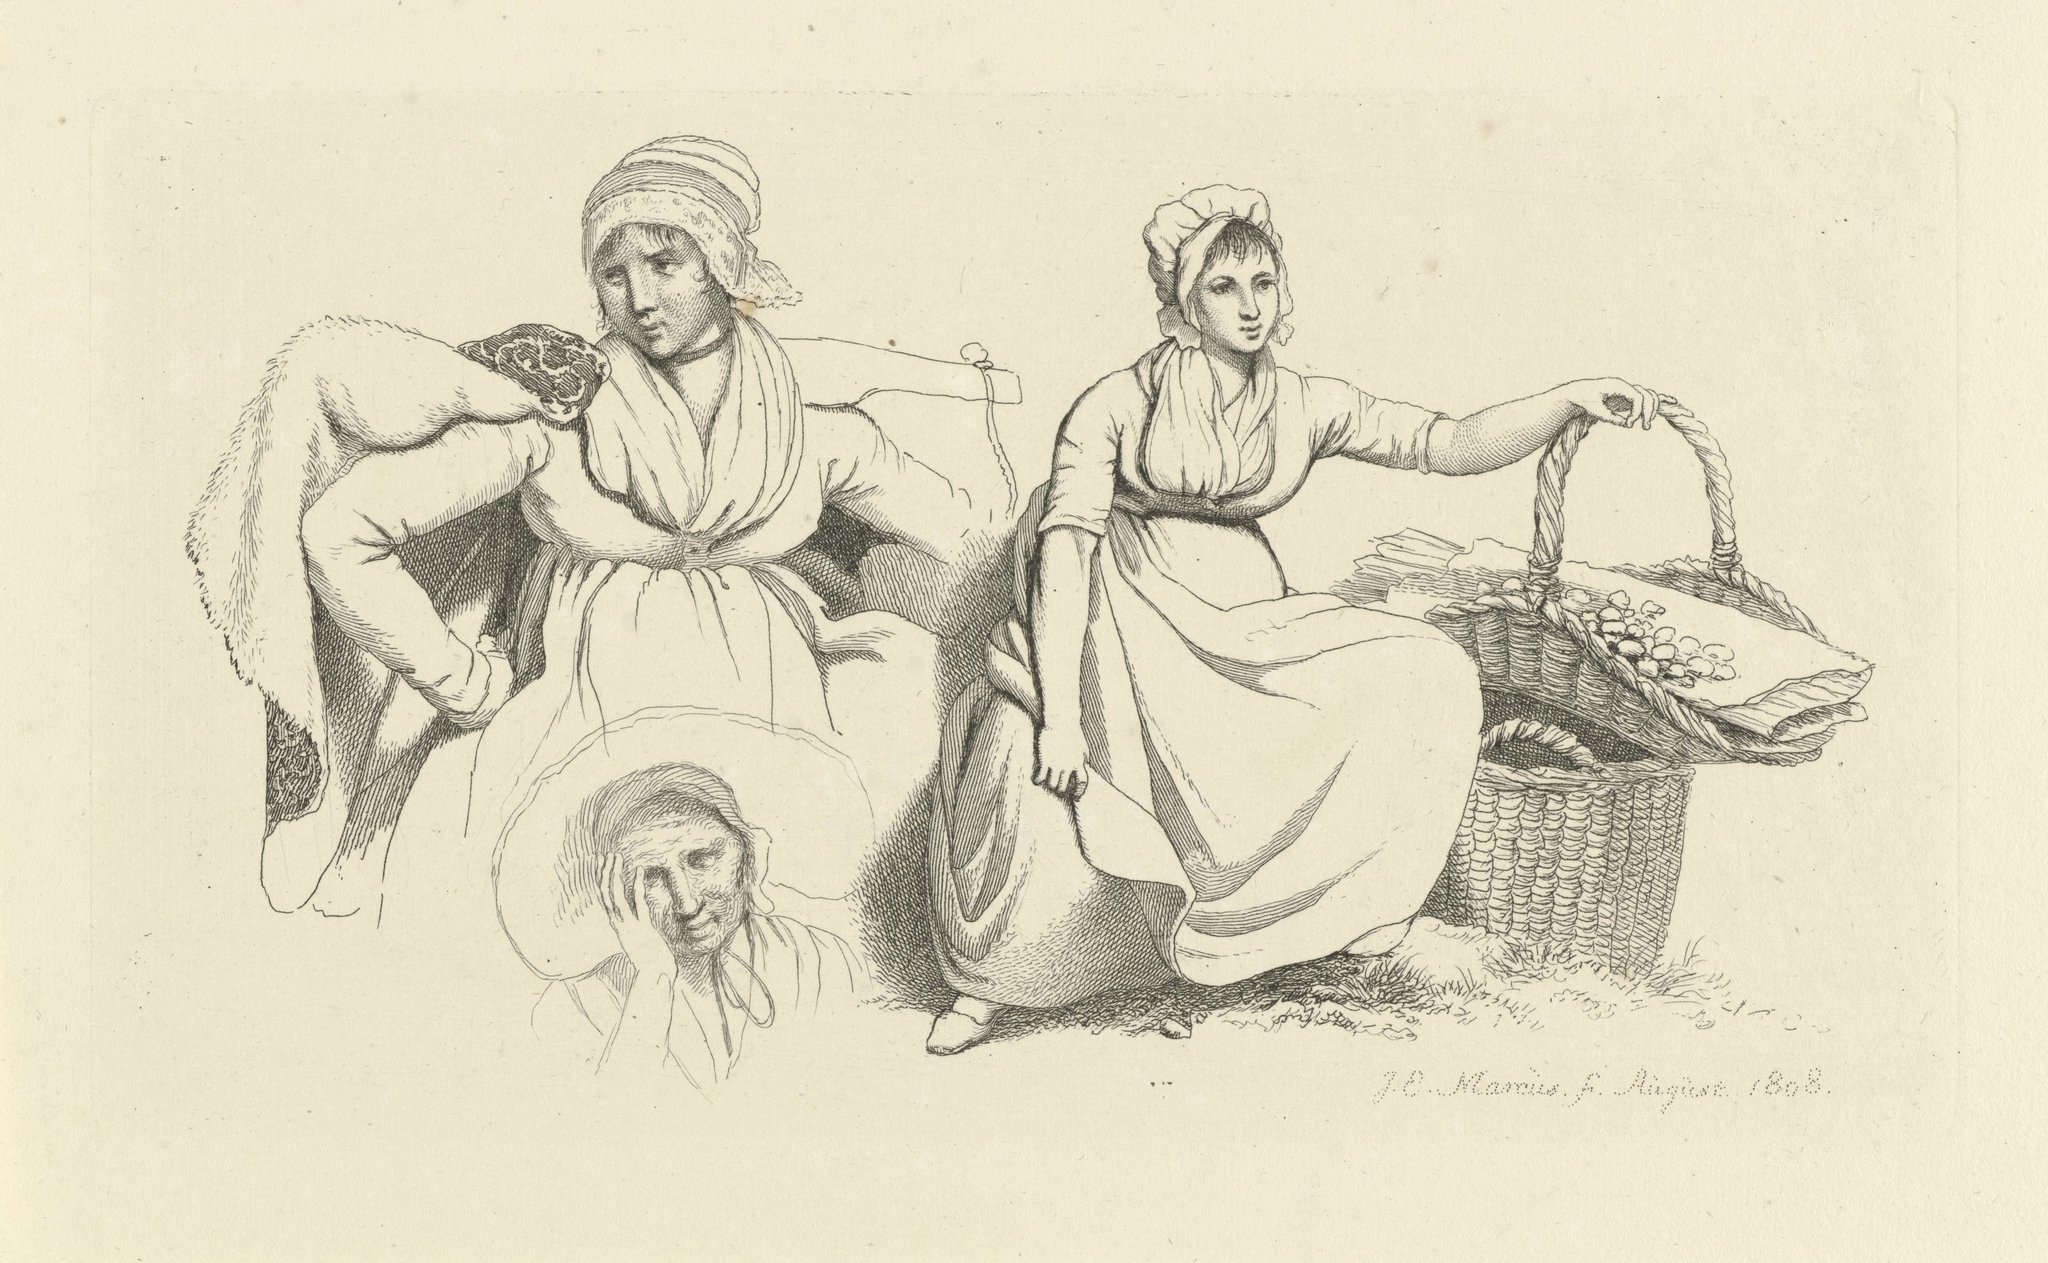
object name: print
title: Studieblad met twee vrouwen en een kop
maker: jacob ernst marcus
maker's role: draughtsman, print maker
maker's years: 1774-1826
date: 1808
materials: paper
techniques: etching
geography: amsterdam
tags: sitting figure - aa - female human figure, container made of plant material other than wood: basket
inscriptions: collector's mark: Lugt 2228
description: Serie voor het eerst uitgegeven door Jacob Ernst Marcus onder de titel Studiebeelden en Fragmenten. Amsterdam: ca.1816. Later heruitgegeven als: Studie-prentwerk/ Etudes gravées.